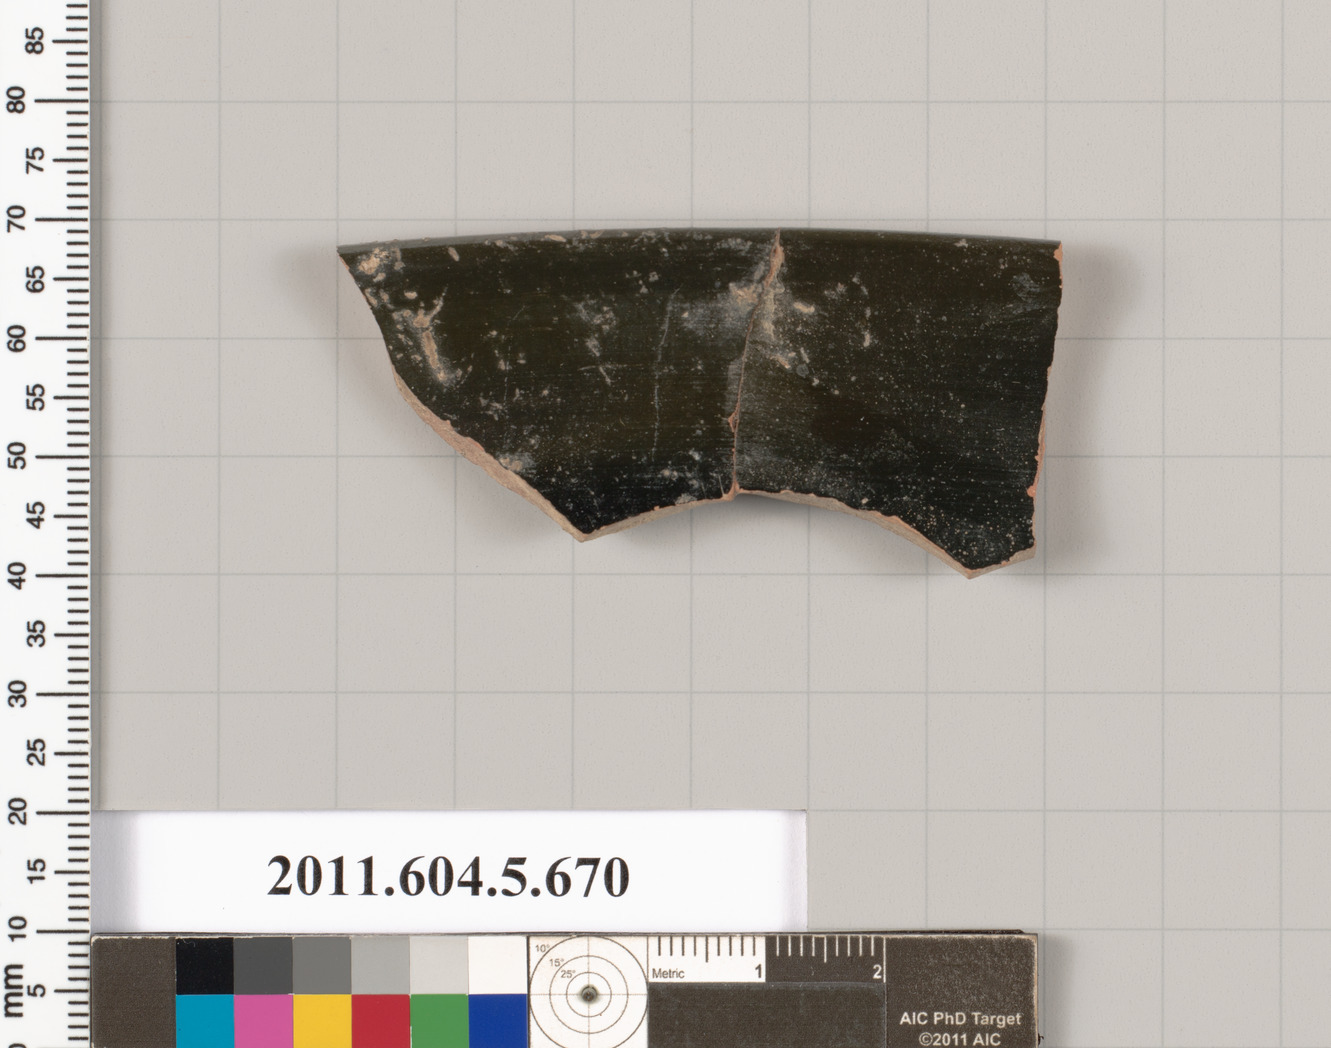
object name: kylix fragment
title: Terracotta rim fragment of a kylix (drinking cup)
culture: greek, attic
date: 600-401 BCE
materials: terracotta